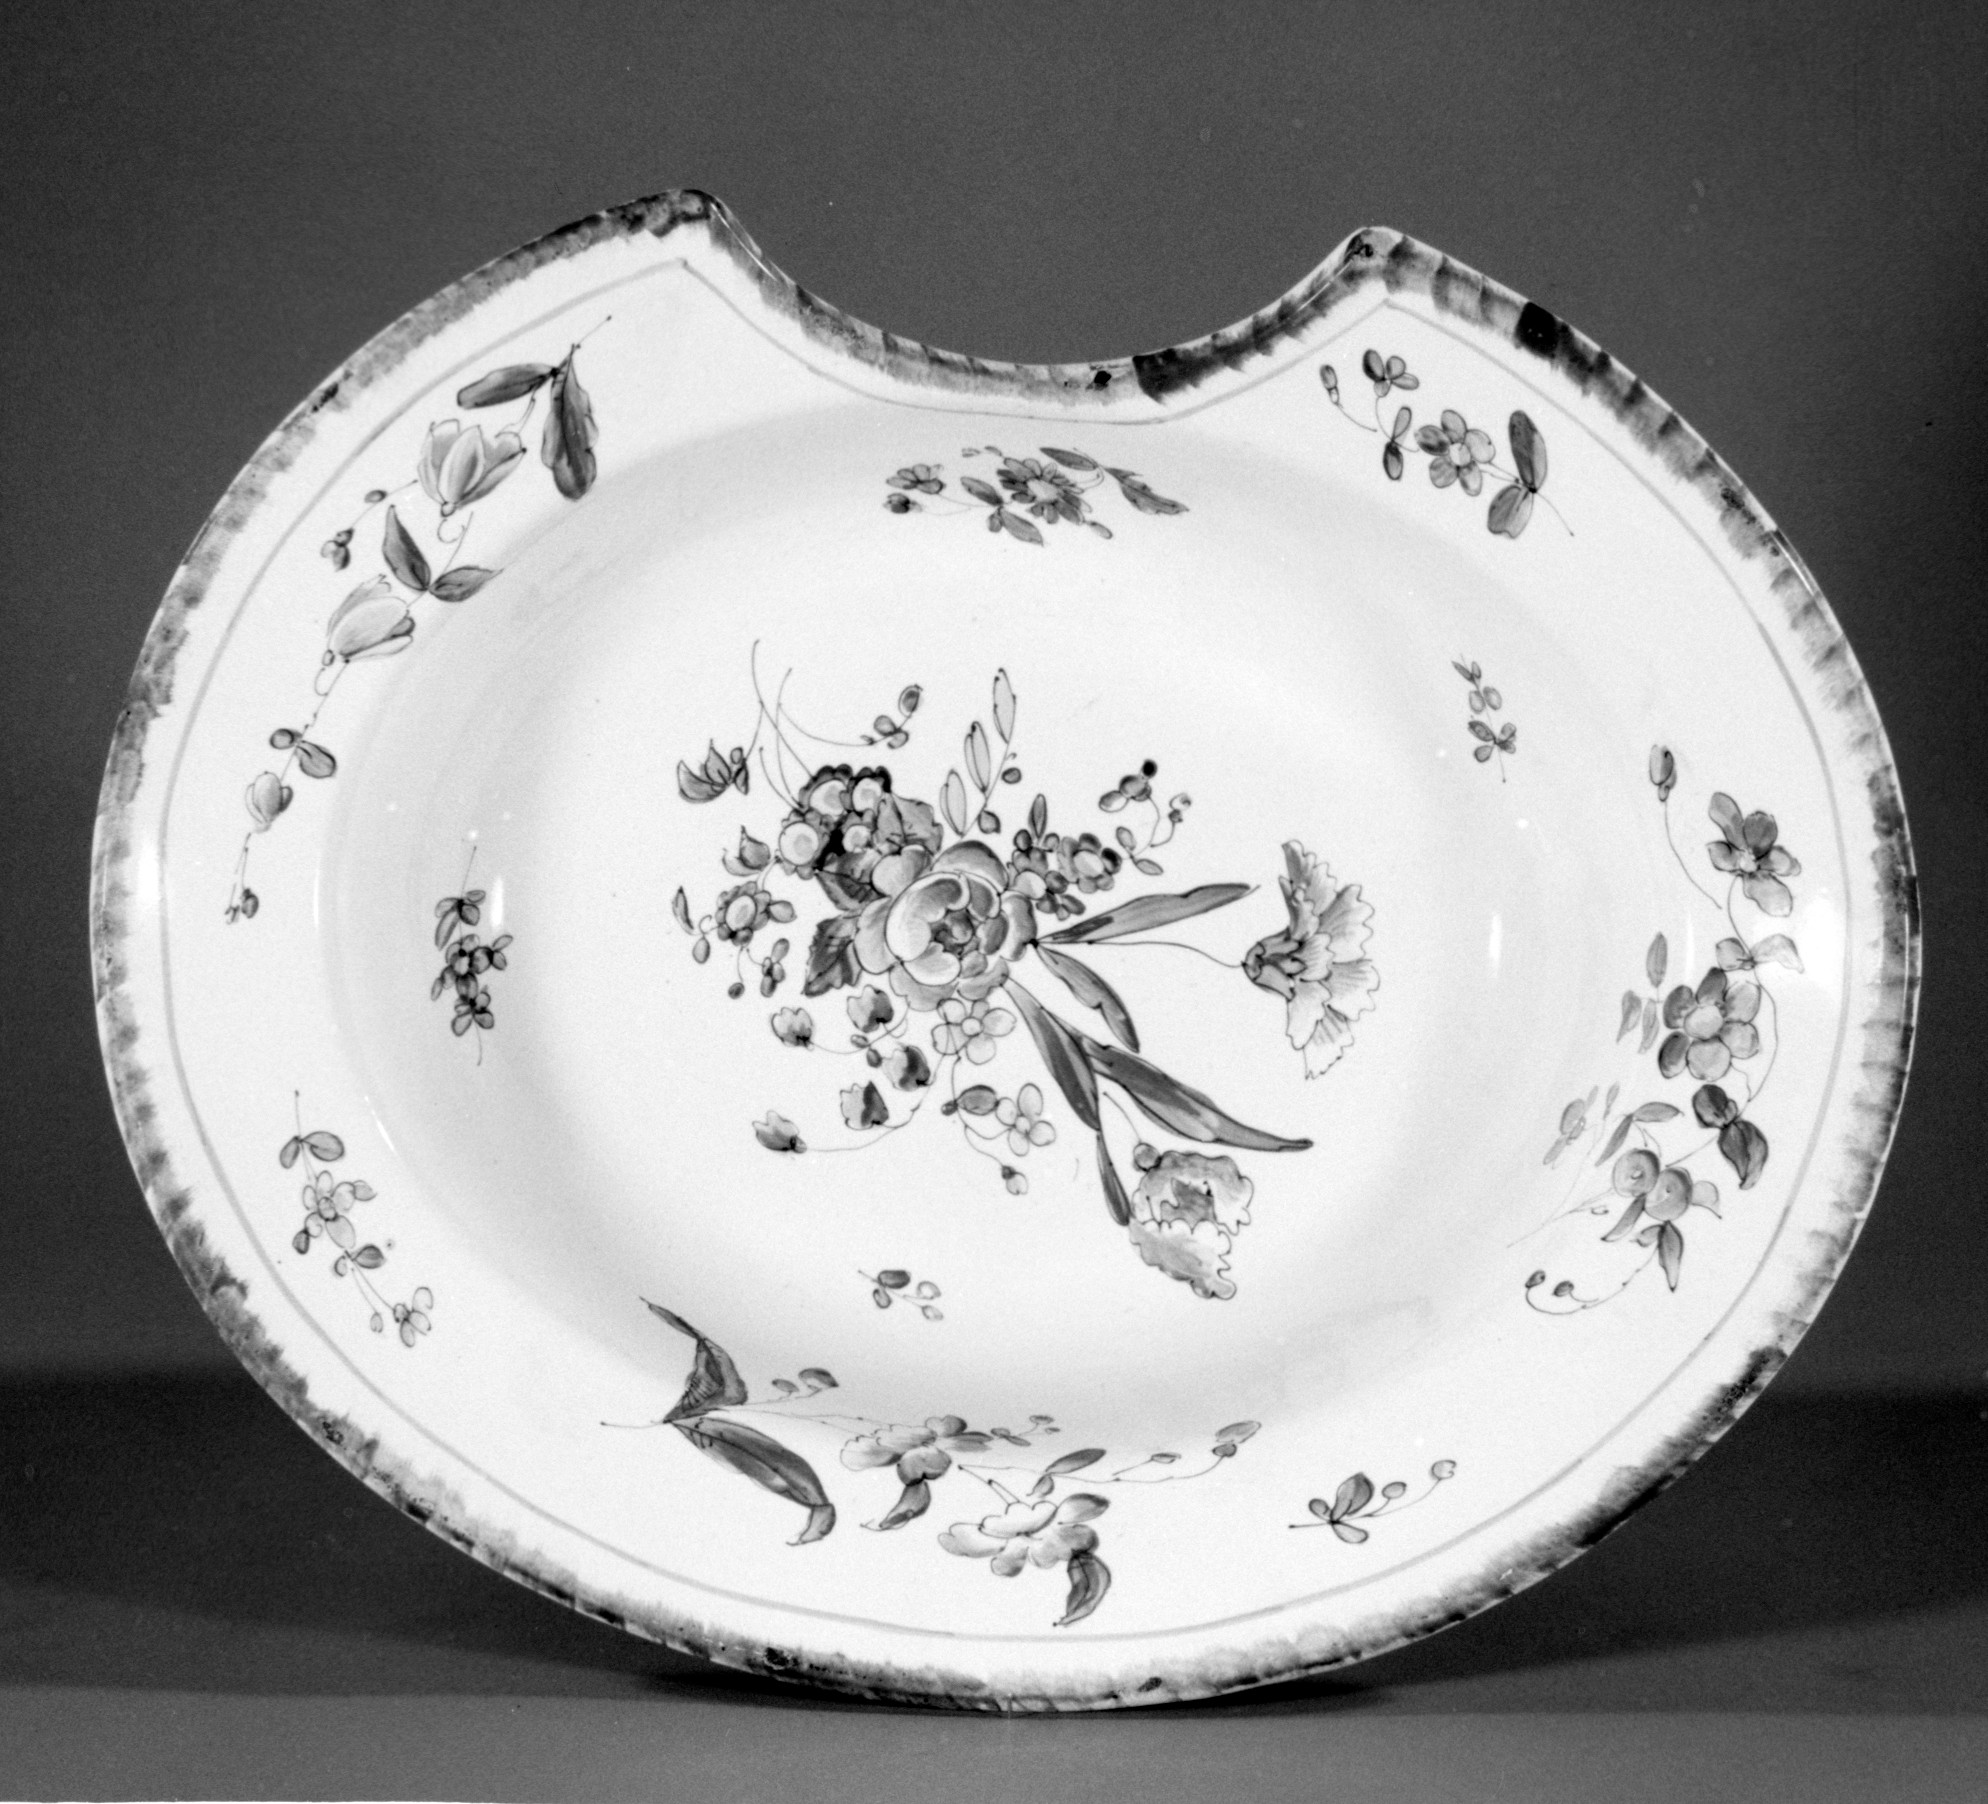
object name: barber's basin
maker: veuve perrin factory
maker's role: maker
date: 1767-1800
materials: faience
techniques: glazing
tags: flowers,leaves